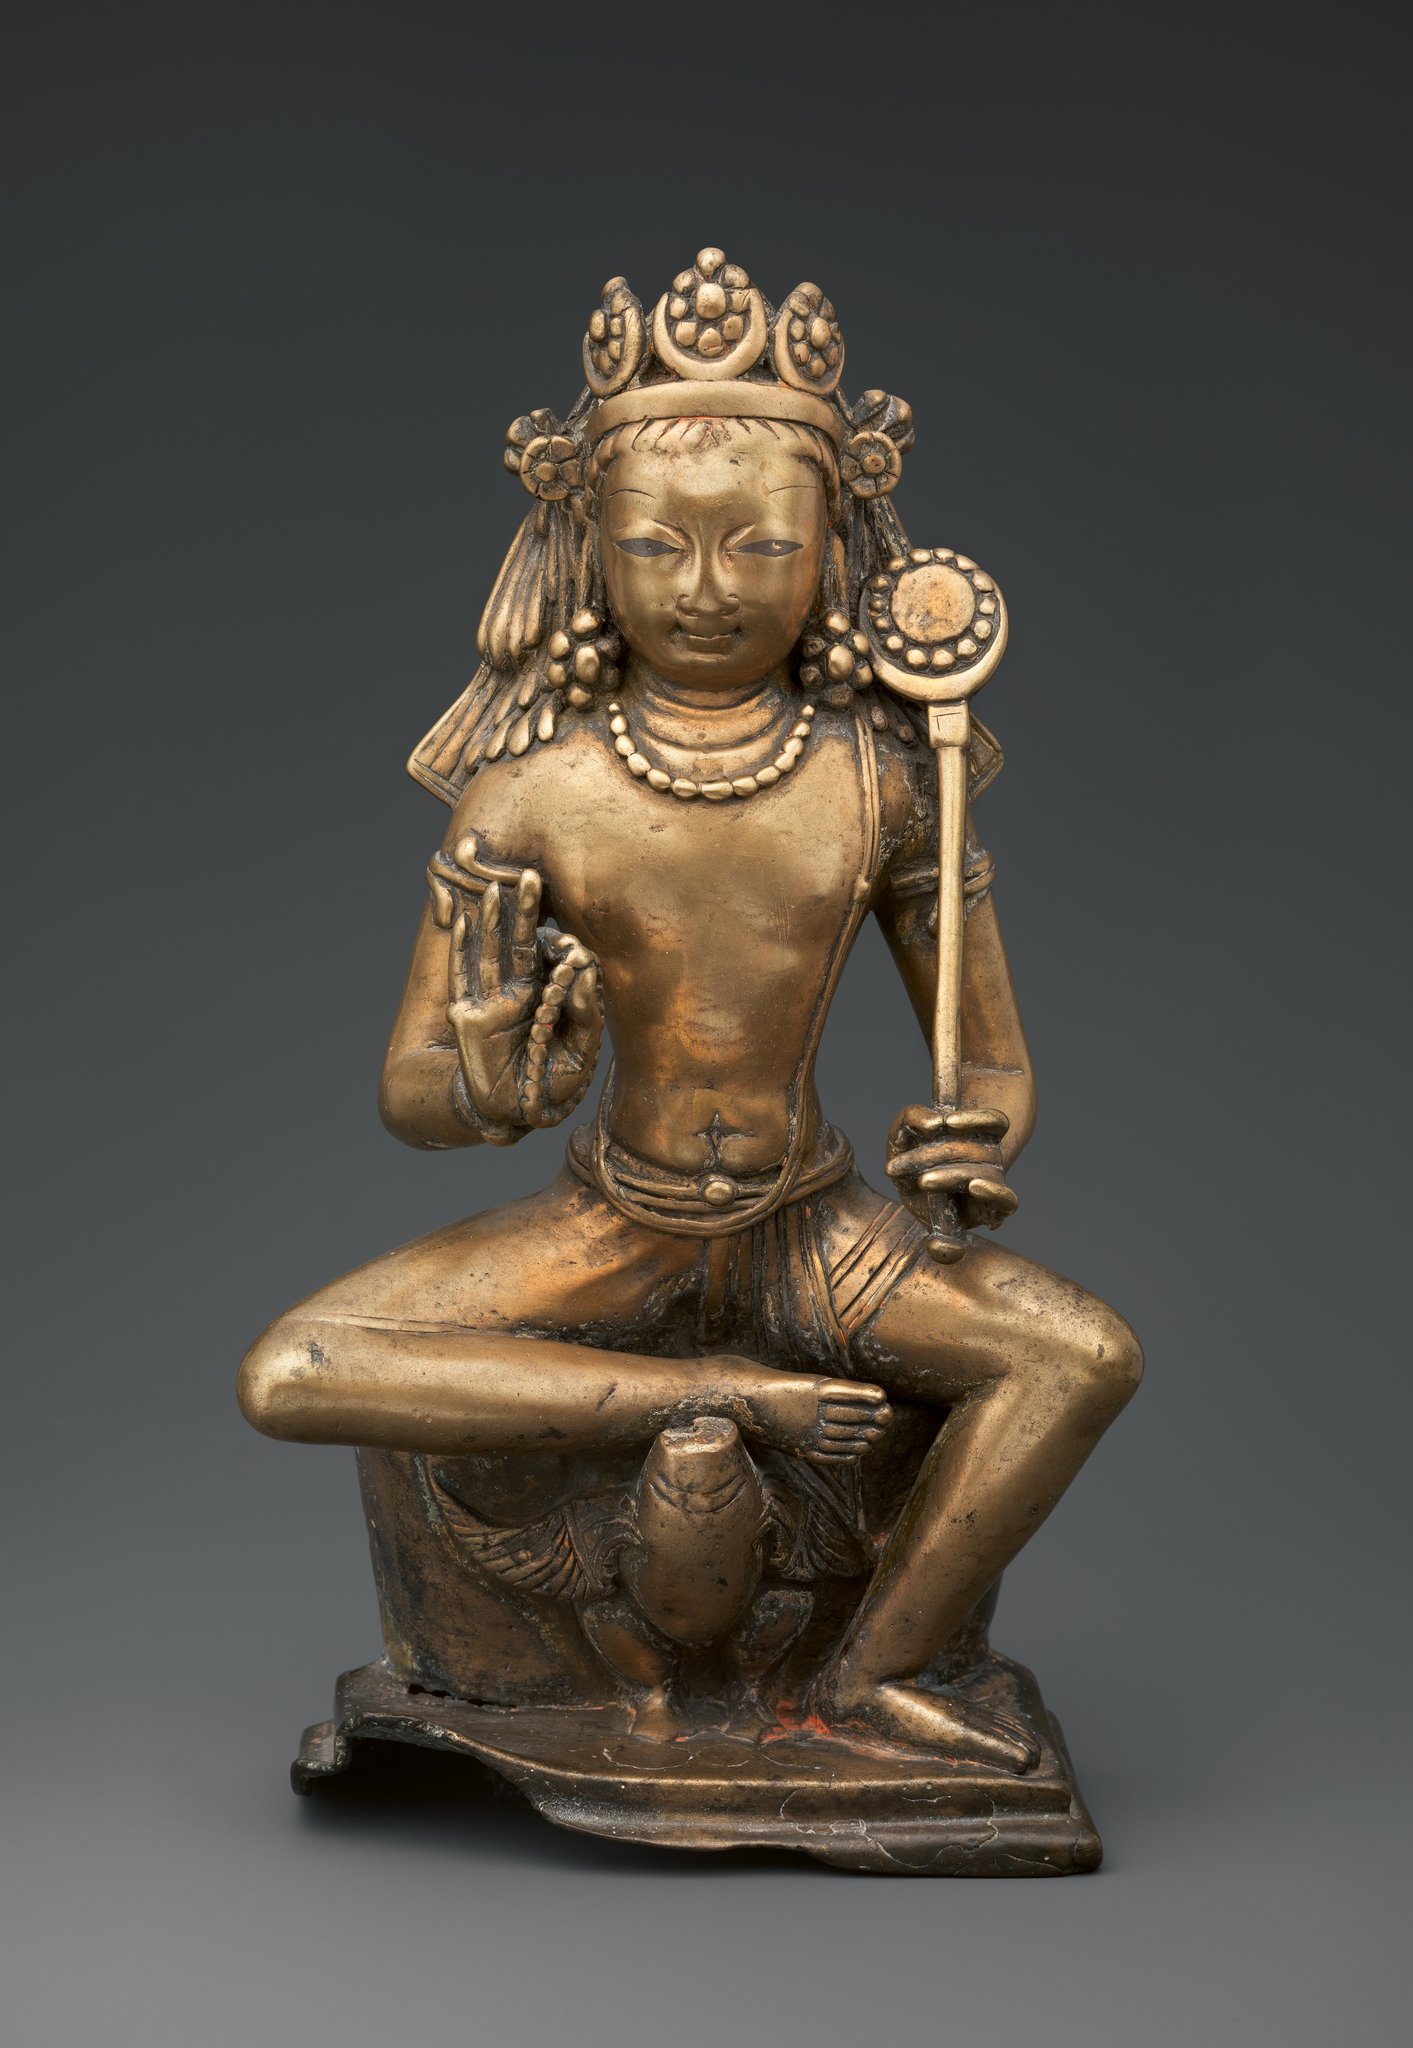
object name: figure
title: Karttikeya, the God of War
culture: kashmiri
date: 701-800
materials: brass, silver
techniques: inlay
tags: kashmir